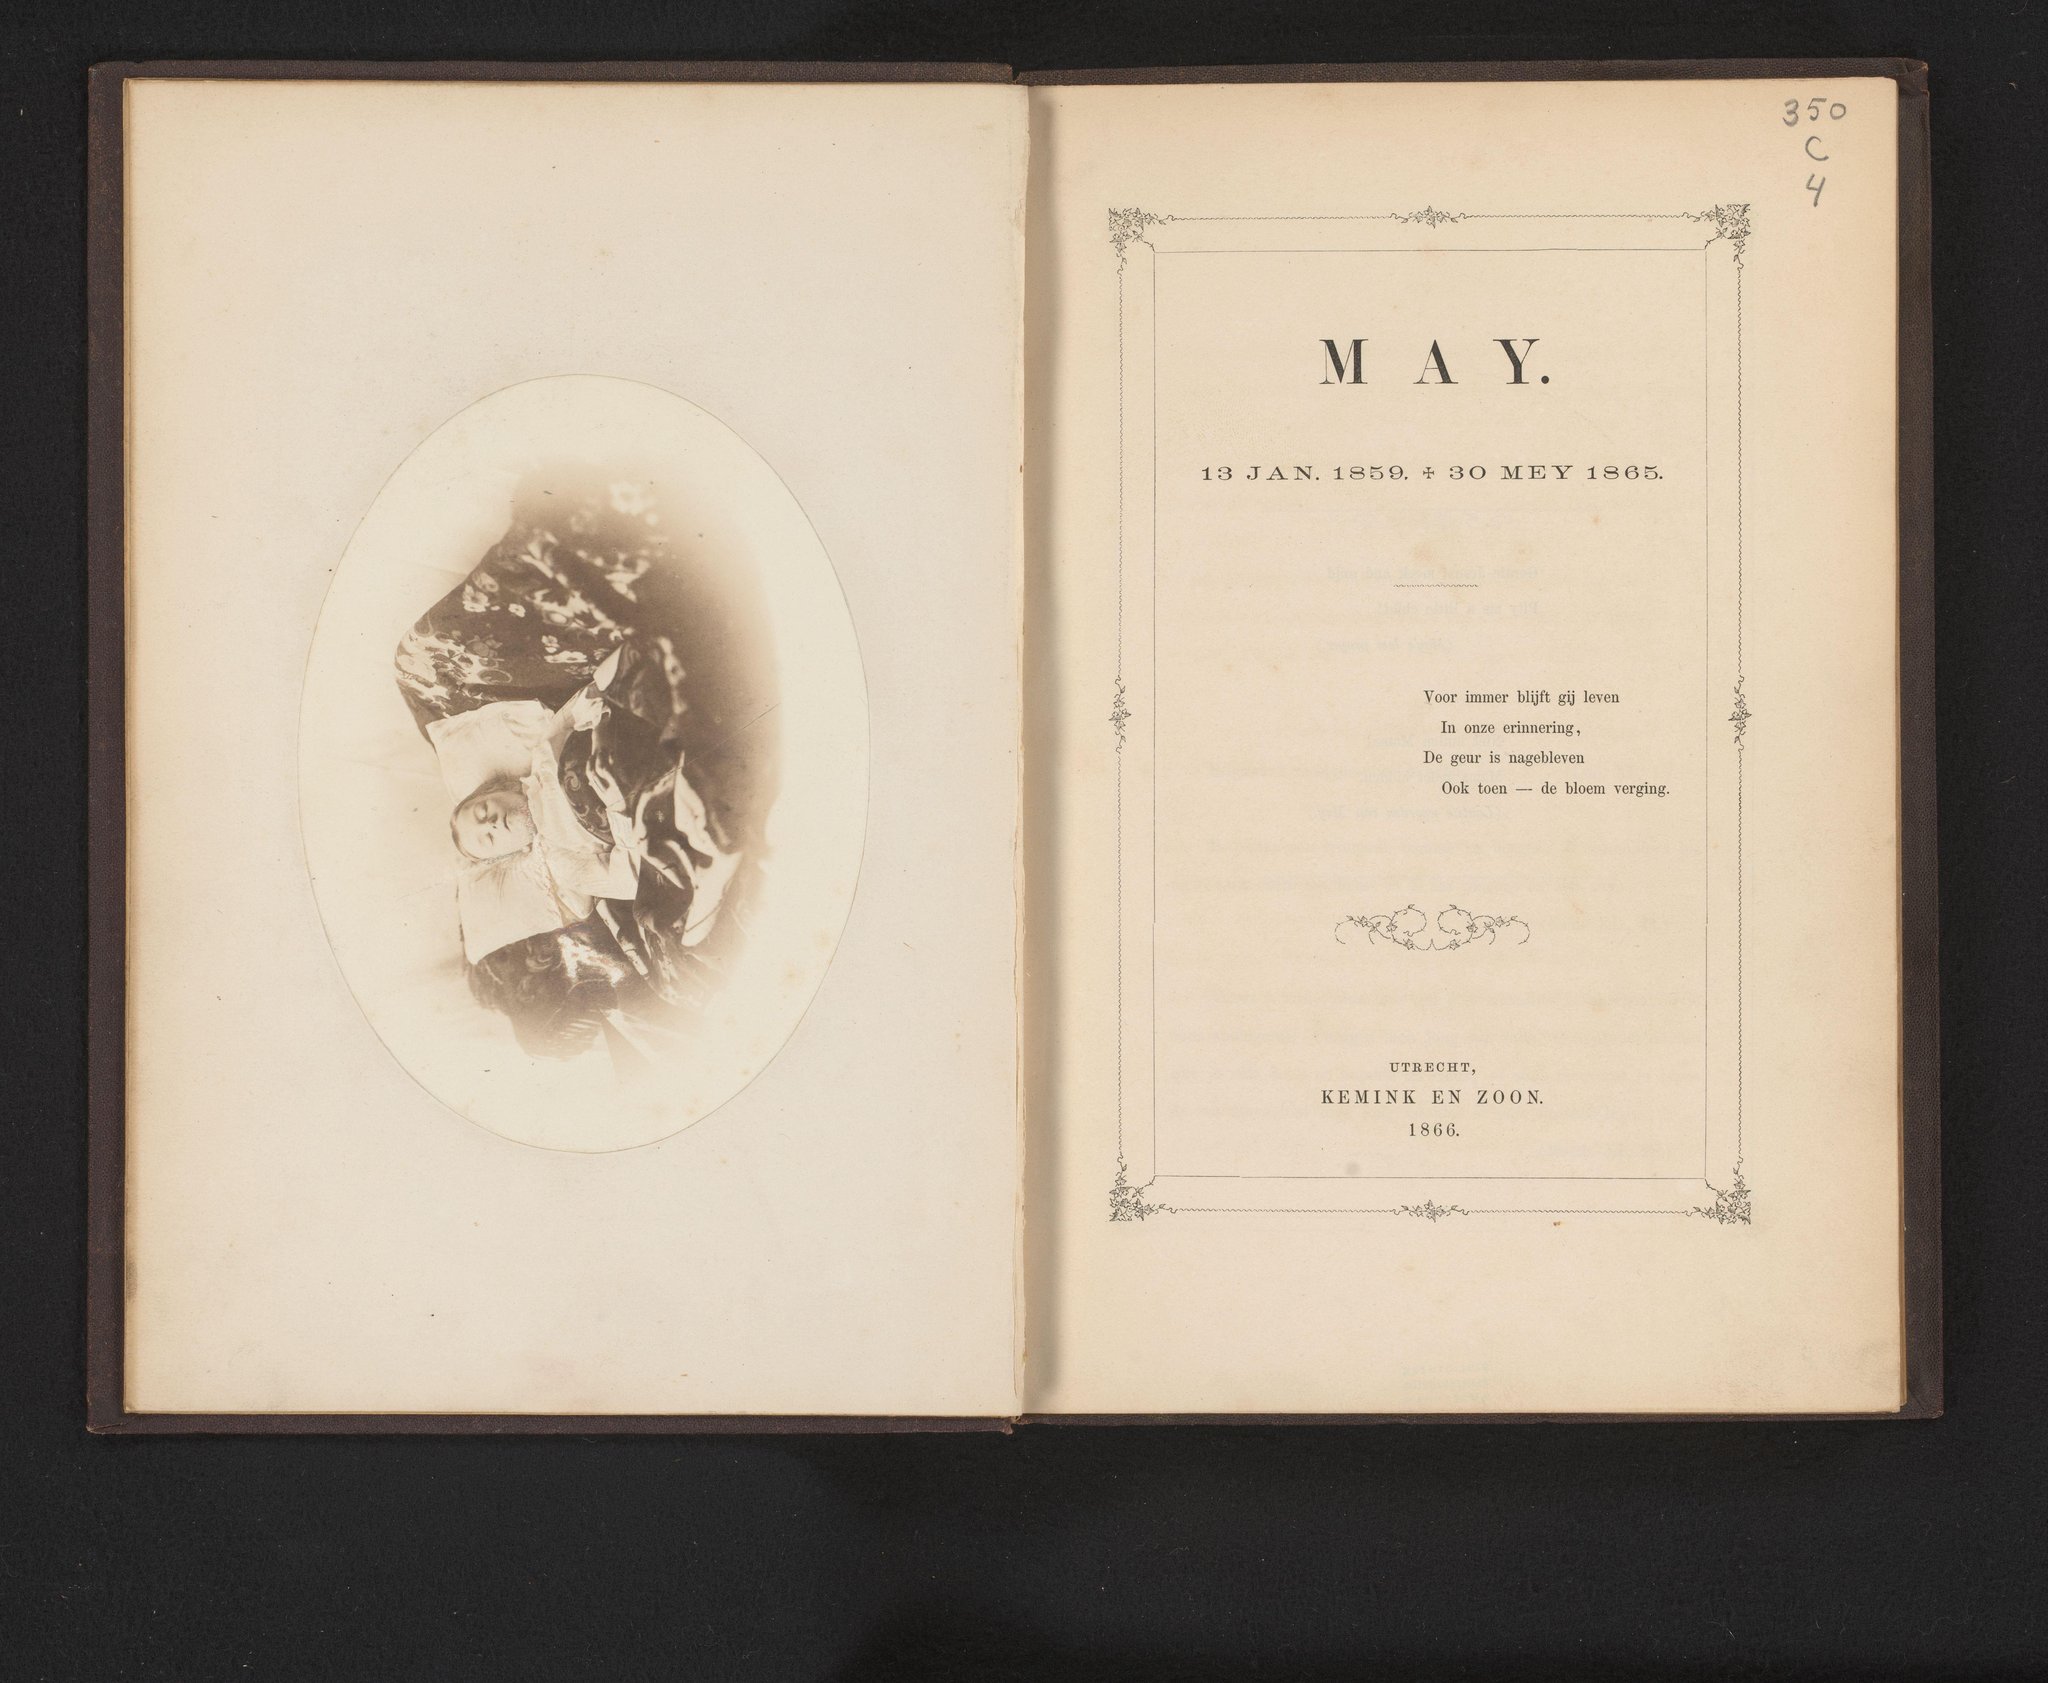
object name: photograph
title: Post-mortemportret van een onbekend zesjarig meisje, aangeduid als May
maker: henri pronk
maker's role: fotograaf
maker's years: 1813-1893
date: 1865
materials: paper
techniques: salted paper print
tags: historical persons, girl (child between toddler and youth)